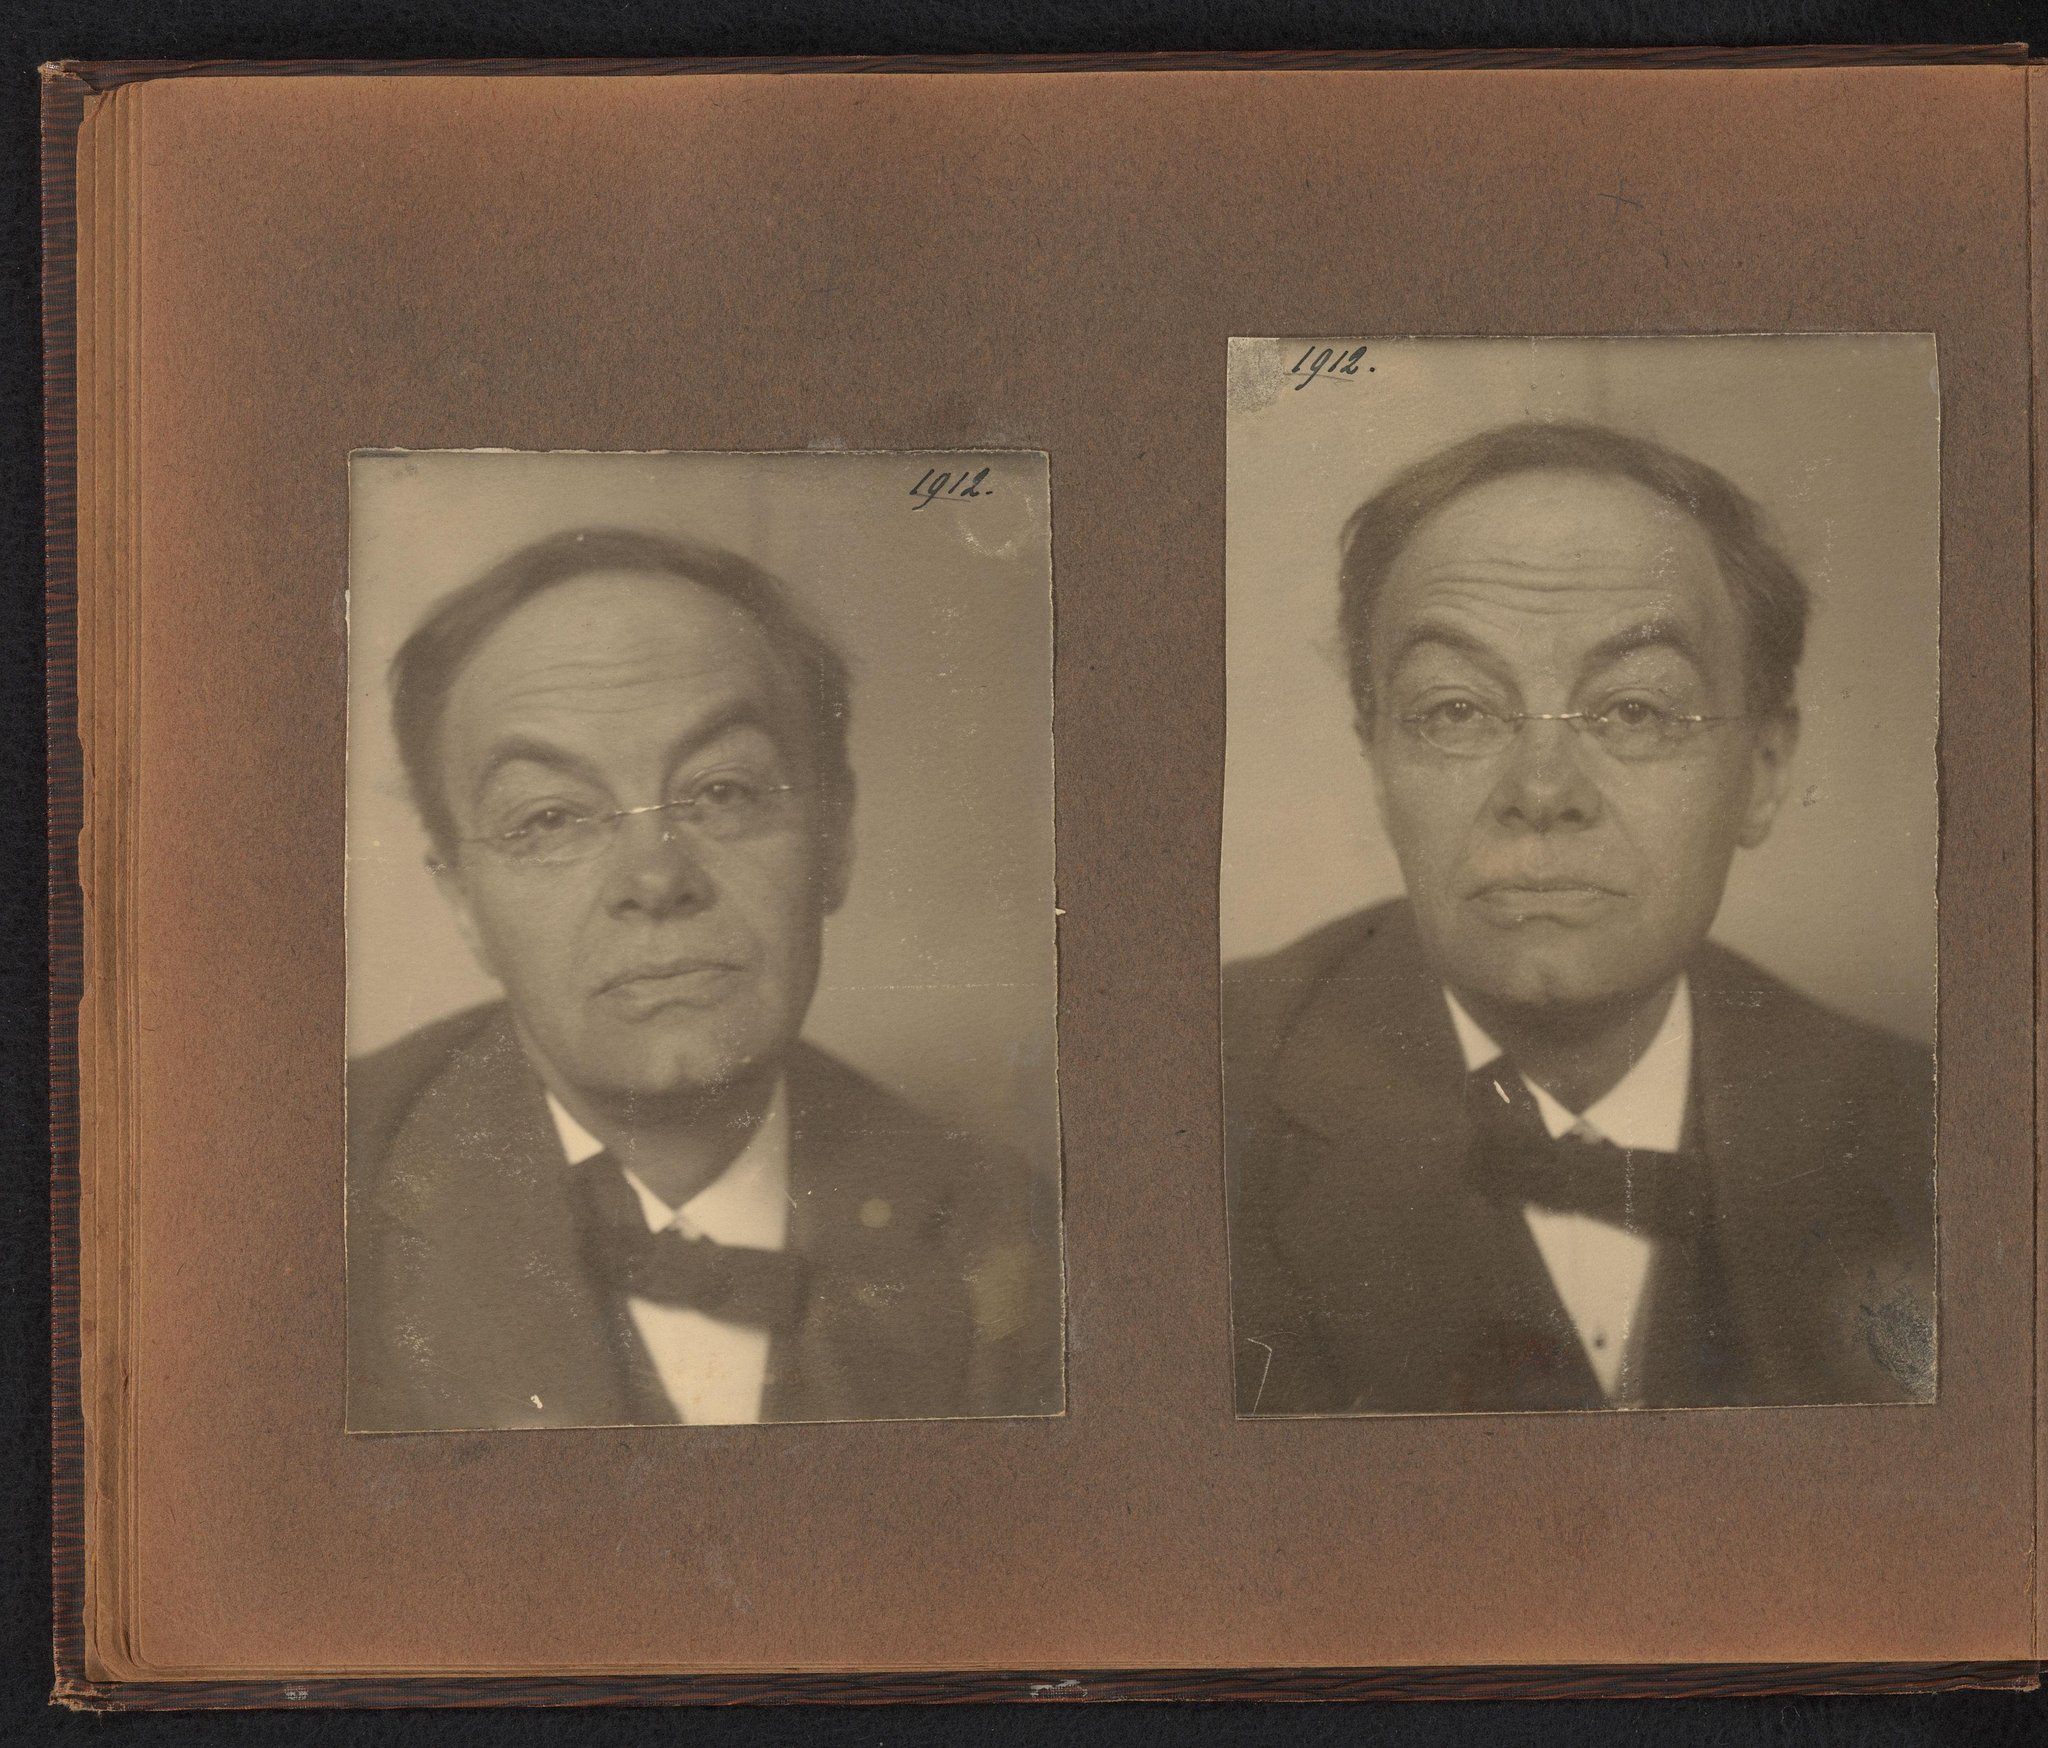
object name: album leaf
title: Bladzijde uit het fotoalbum van de familie Diepenbrock met 2 portretten van Alphons Diepenbrock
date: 1912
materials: cardboard, photographic support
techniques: photography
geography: amsterdam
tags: amsterdam, alphons diepenbrock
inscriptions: inscription: ‘1912. 1912.’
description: Bruin albumblad 10 van familiealbum van Alphons Diepenbrock.